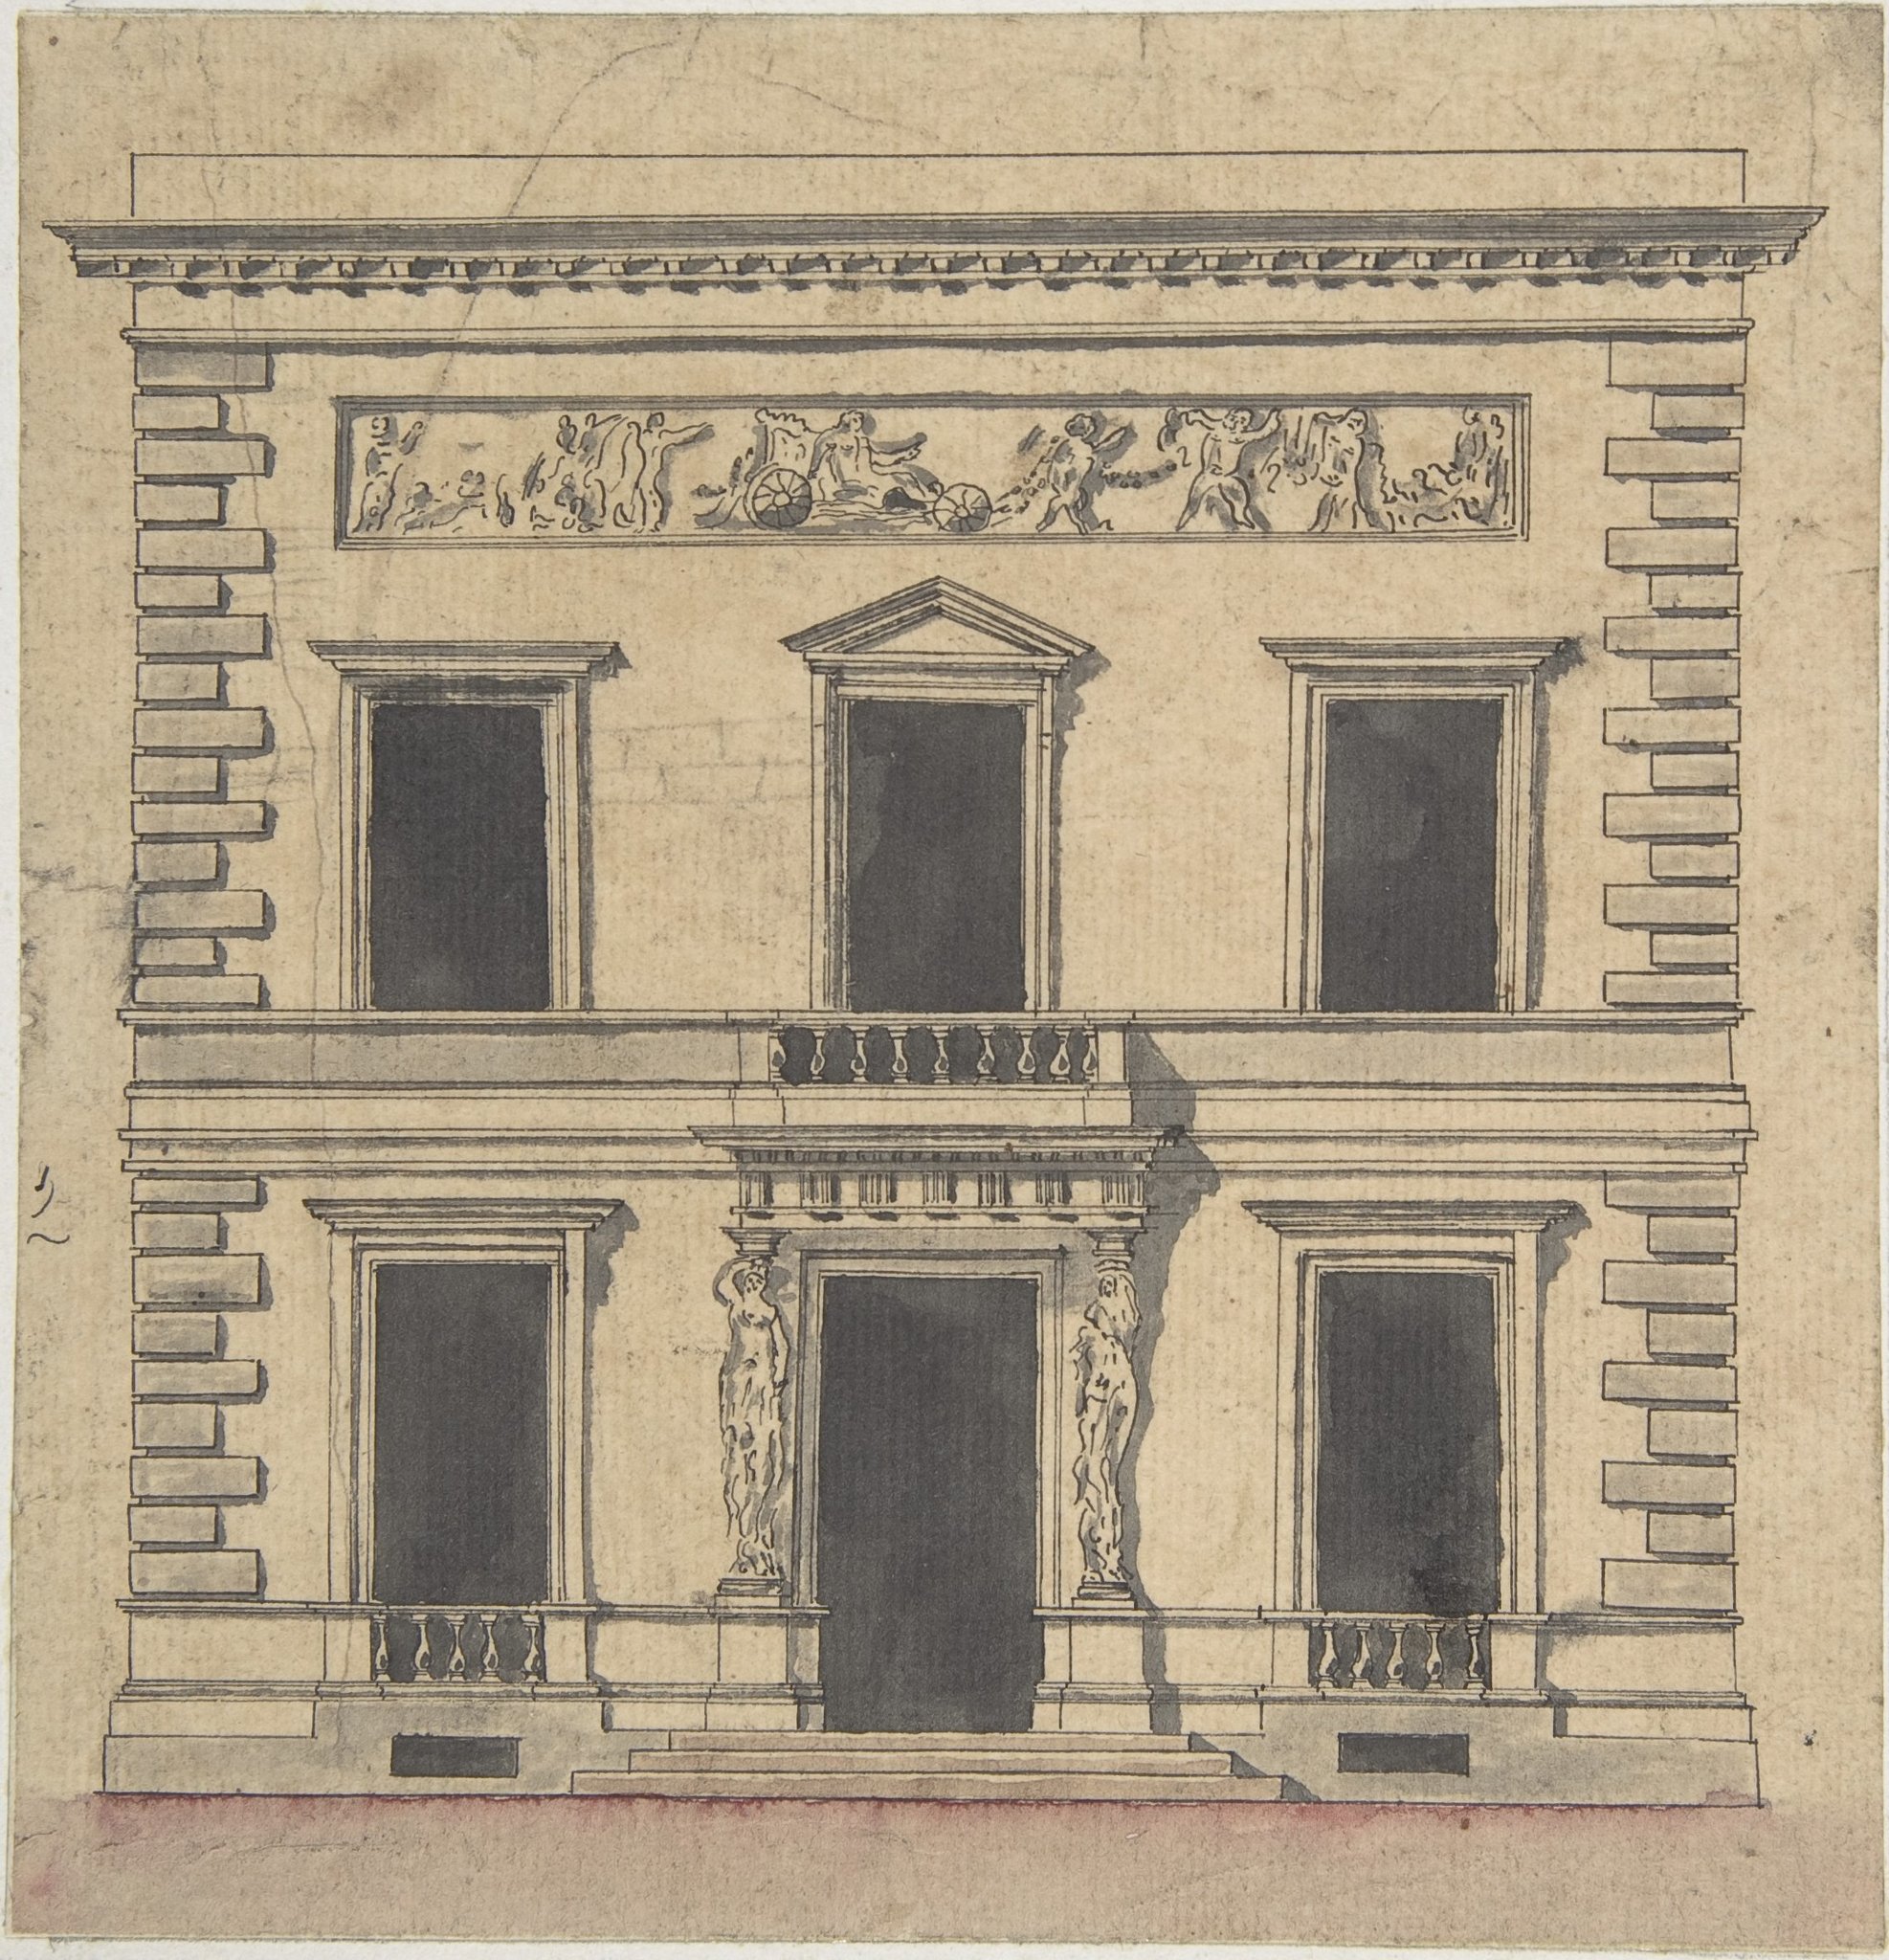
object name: drawing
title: Design for a Stage Set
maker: claude nicolas ledoux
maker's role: artist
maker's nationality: french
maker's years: 1736-1806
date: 1736-1806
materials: ink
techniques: brush, pen, wash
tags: buildings,stage design